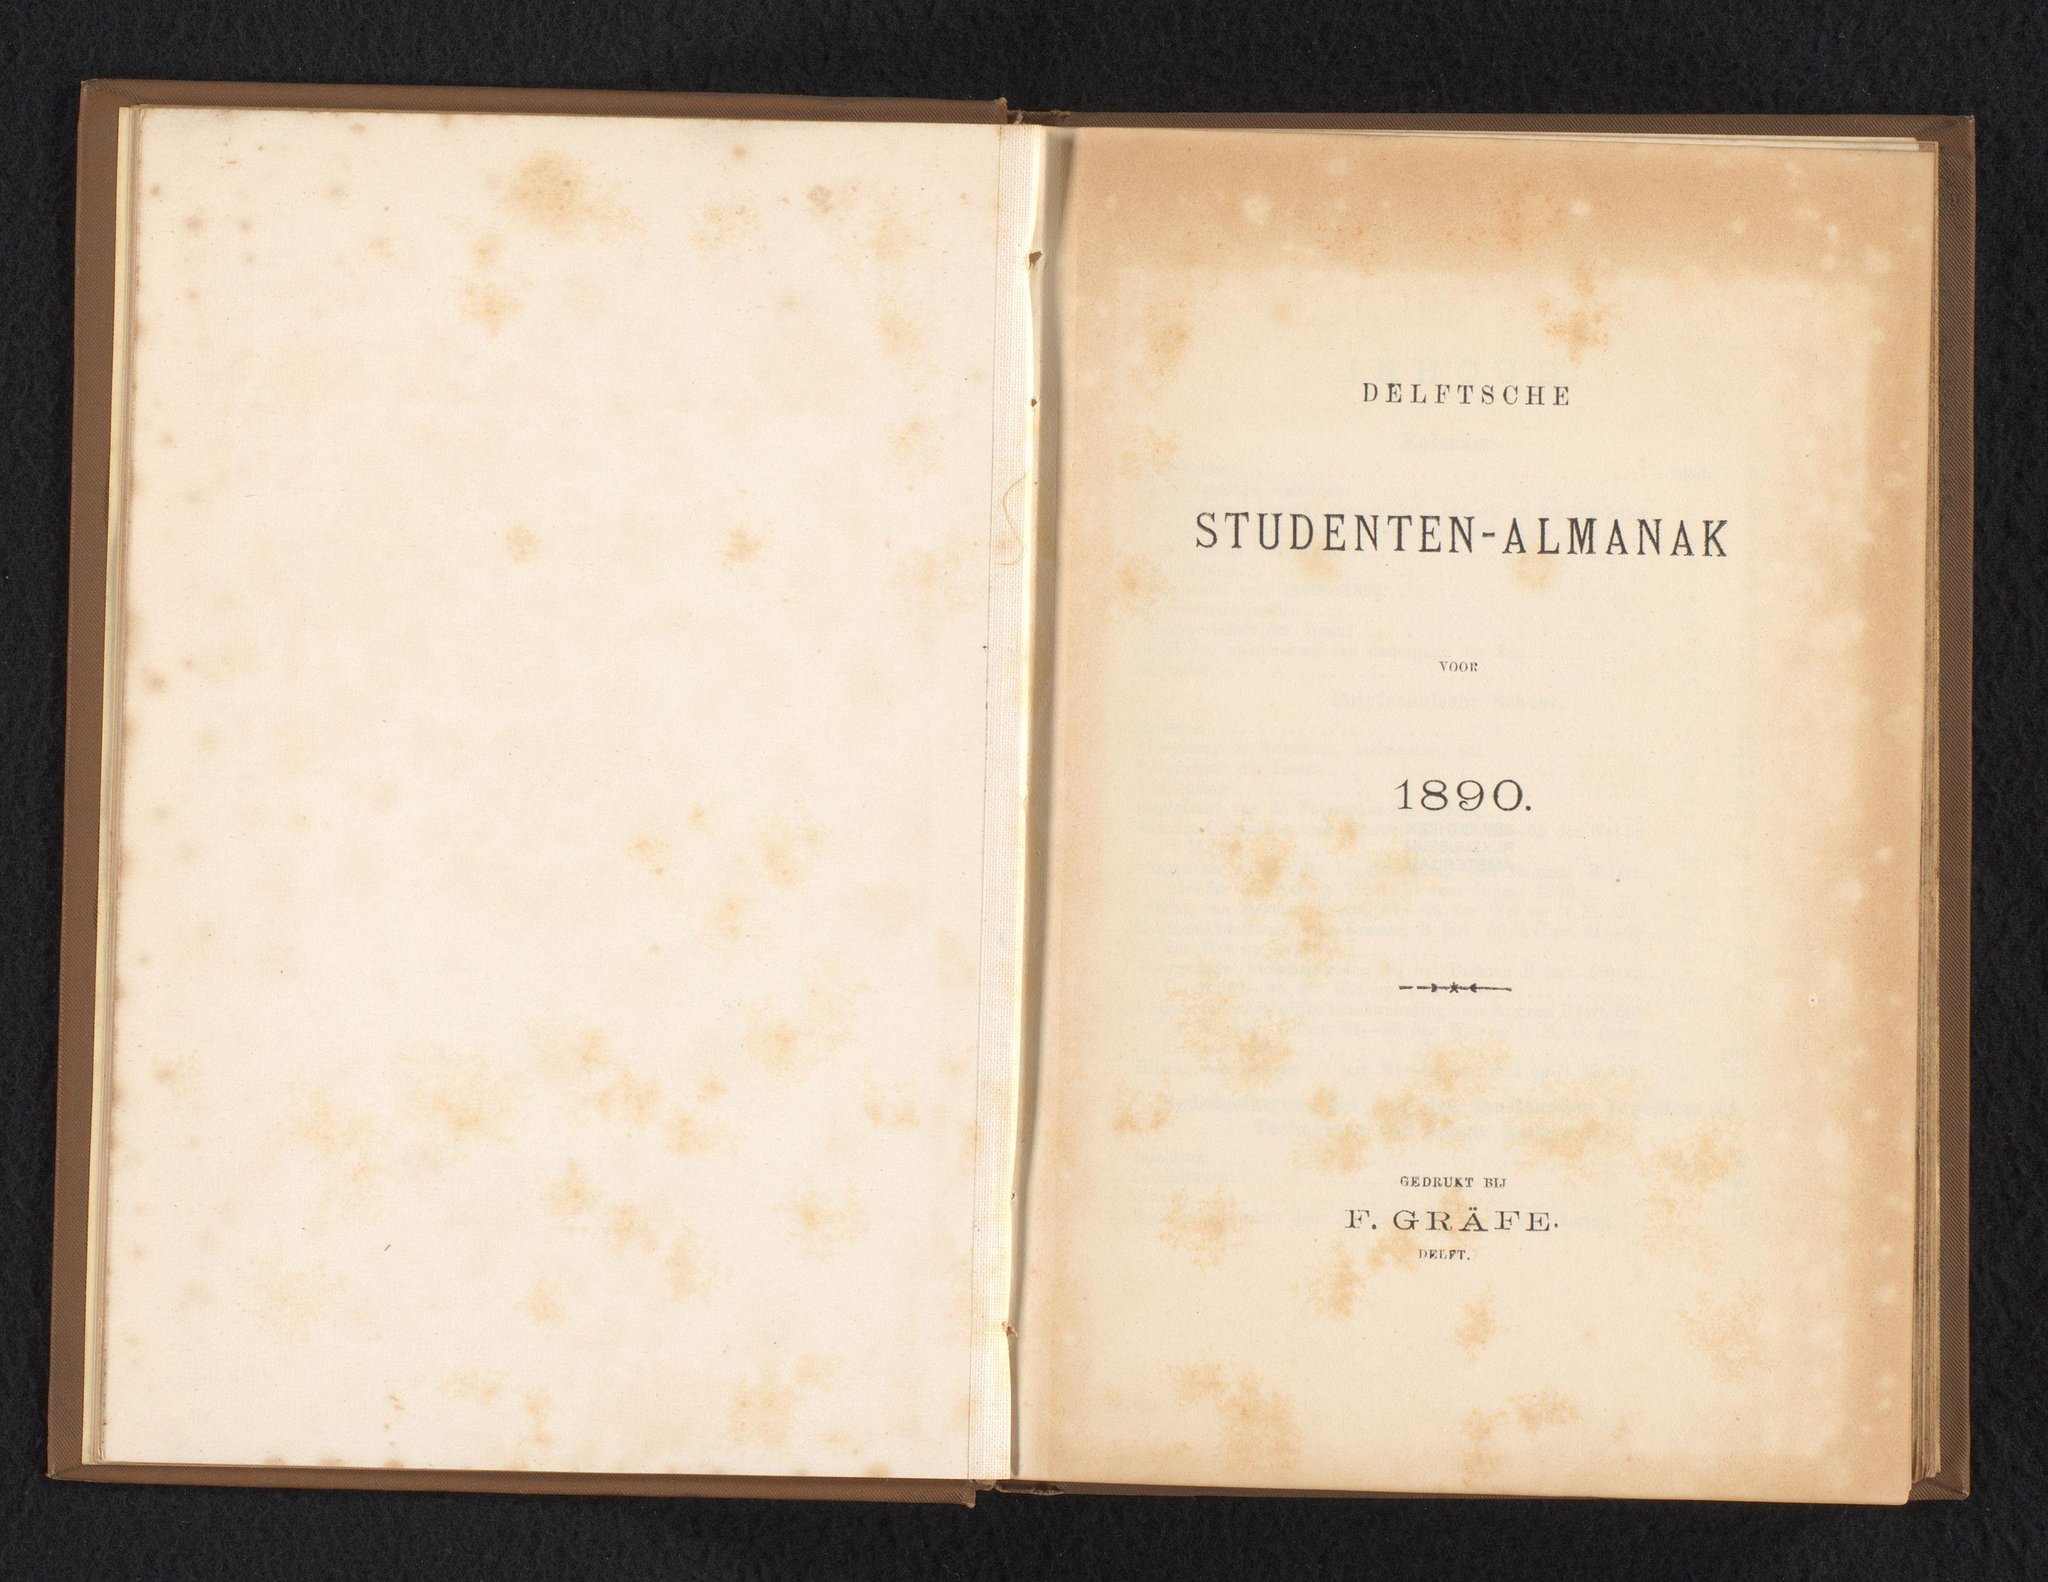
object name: book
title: Delftsche studenten-almanak voor 1890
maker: frederik christiaan filip gräfe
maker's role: fotograaf, lithograaf, steendrukker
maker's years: 1835-1905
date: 1890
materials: paper, cardboard, linen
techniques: albumen print, letterpress printing, lithograph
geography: delft